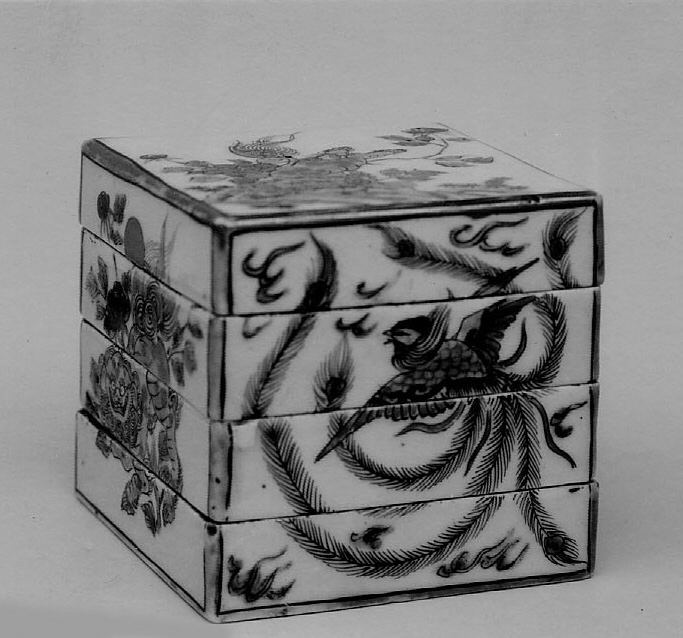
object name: incense box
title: Box for Incense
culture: japanese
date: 1750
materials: enamel, gold, porcelain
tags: birds,leaves